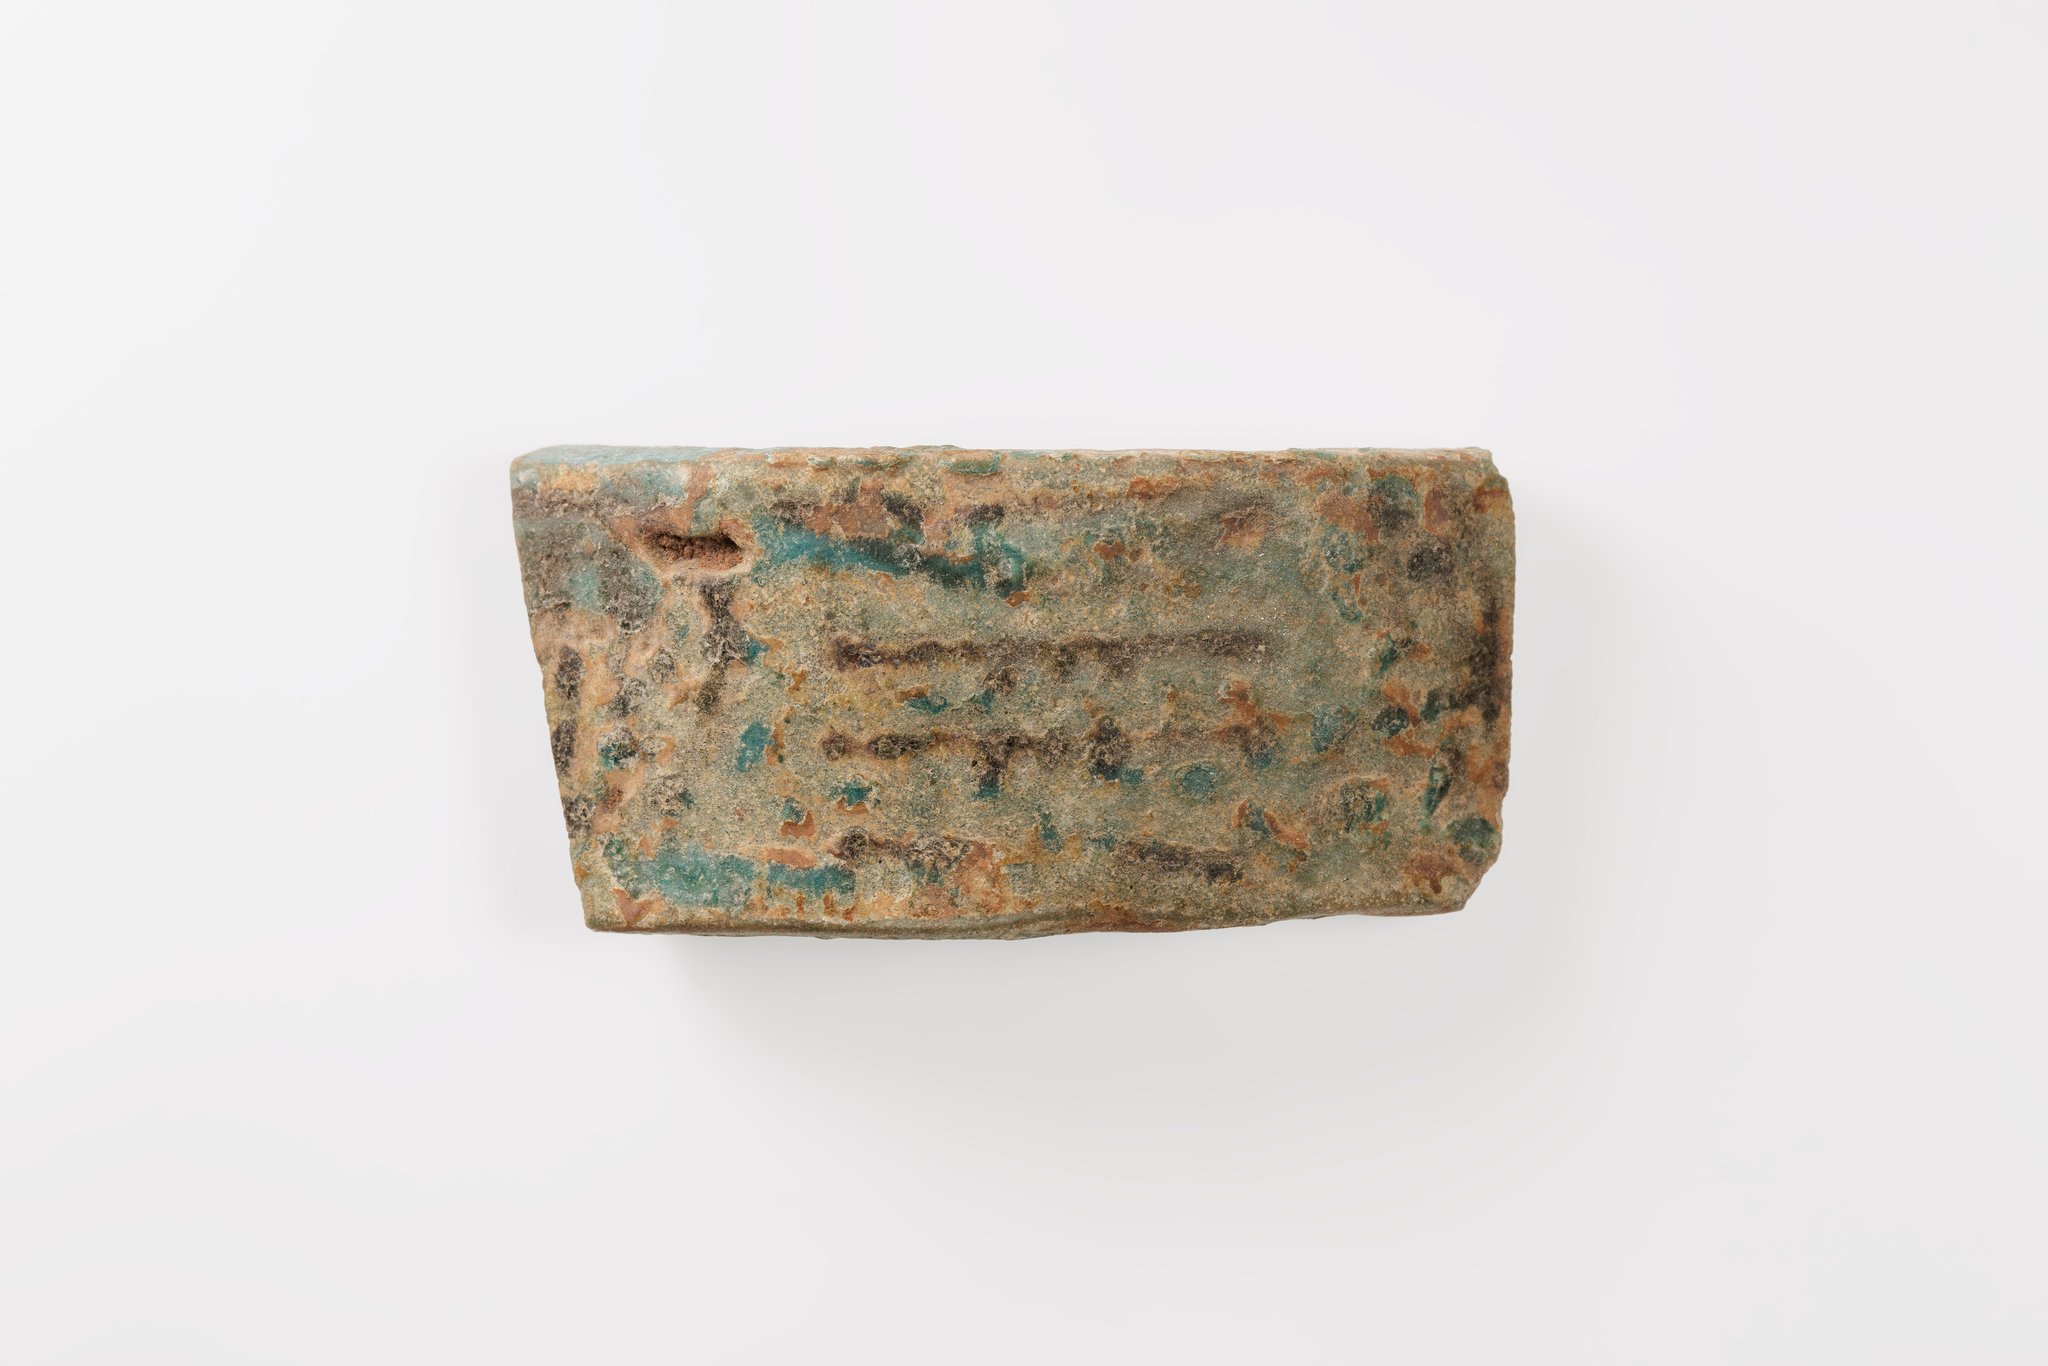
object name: votive bracelet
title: Fragment of a votive bracelet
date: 1295-1070 BCE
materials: faience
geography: egypt